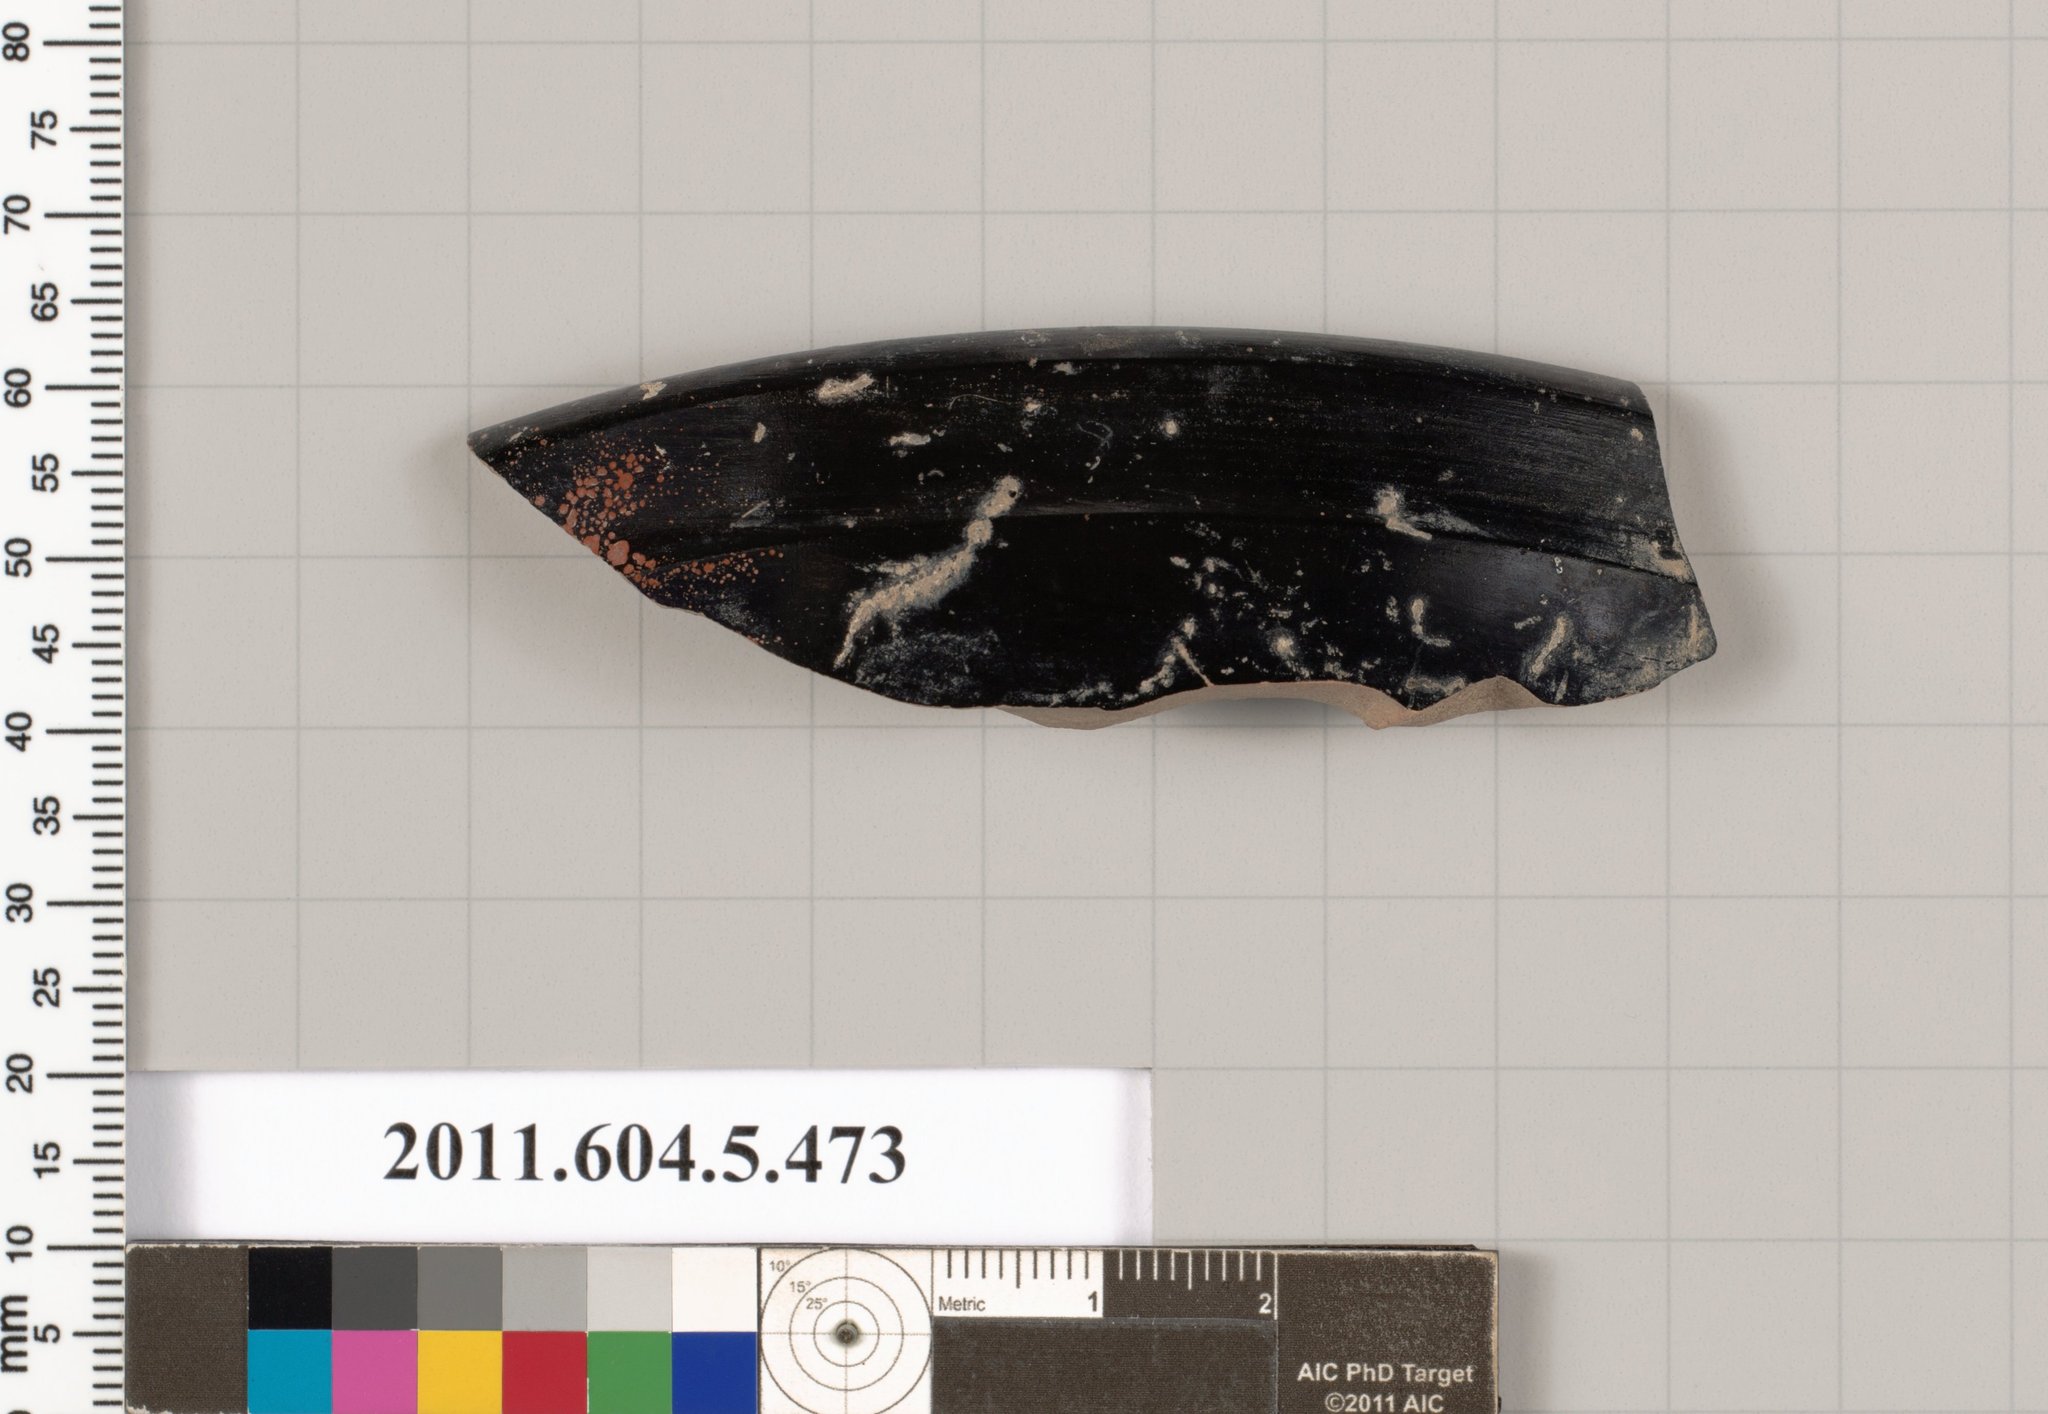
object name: kylix fragment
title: Terracotta rim fragment of a kylix (drinking cup)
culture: greek, attic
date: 600-401 BCE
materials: terracotta